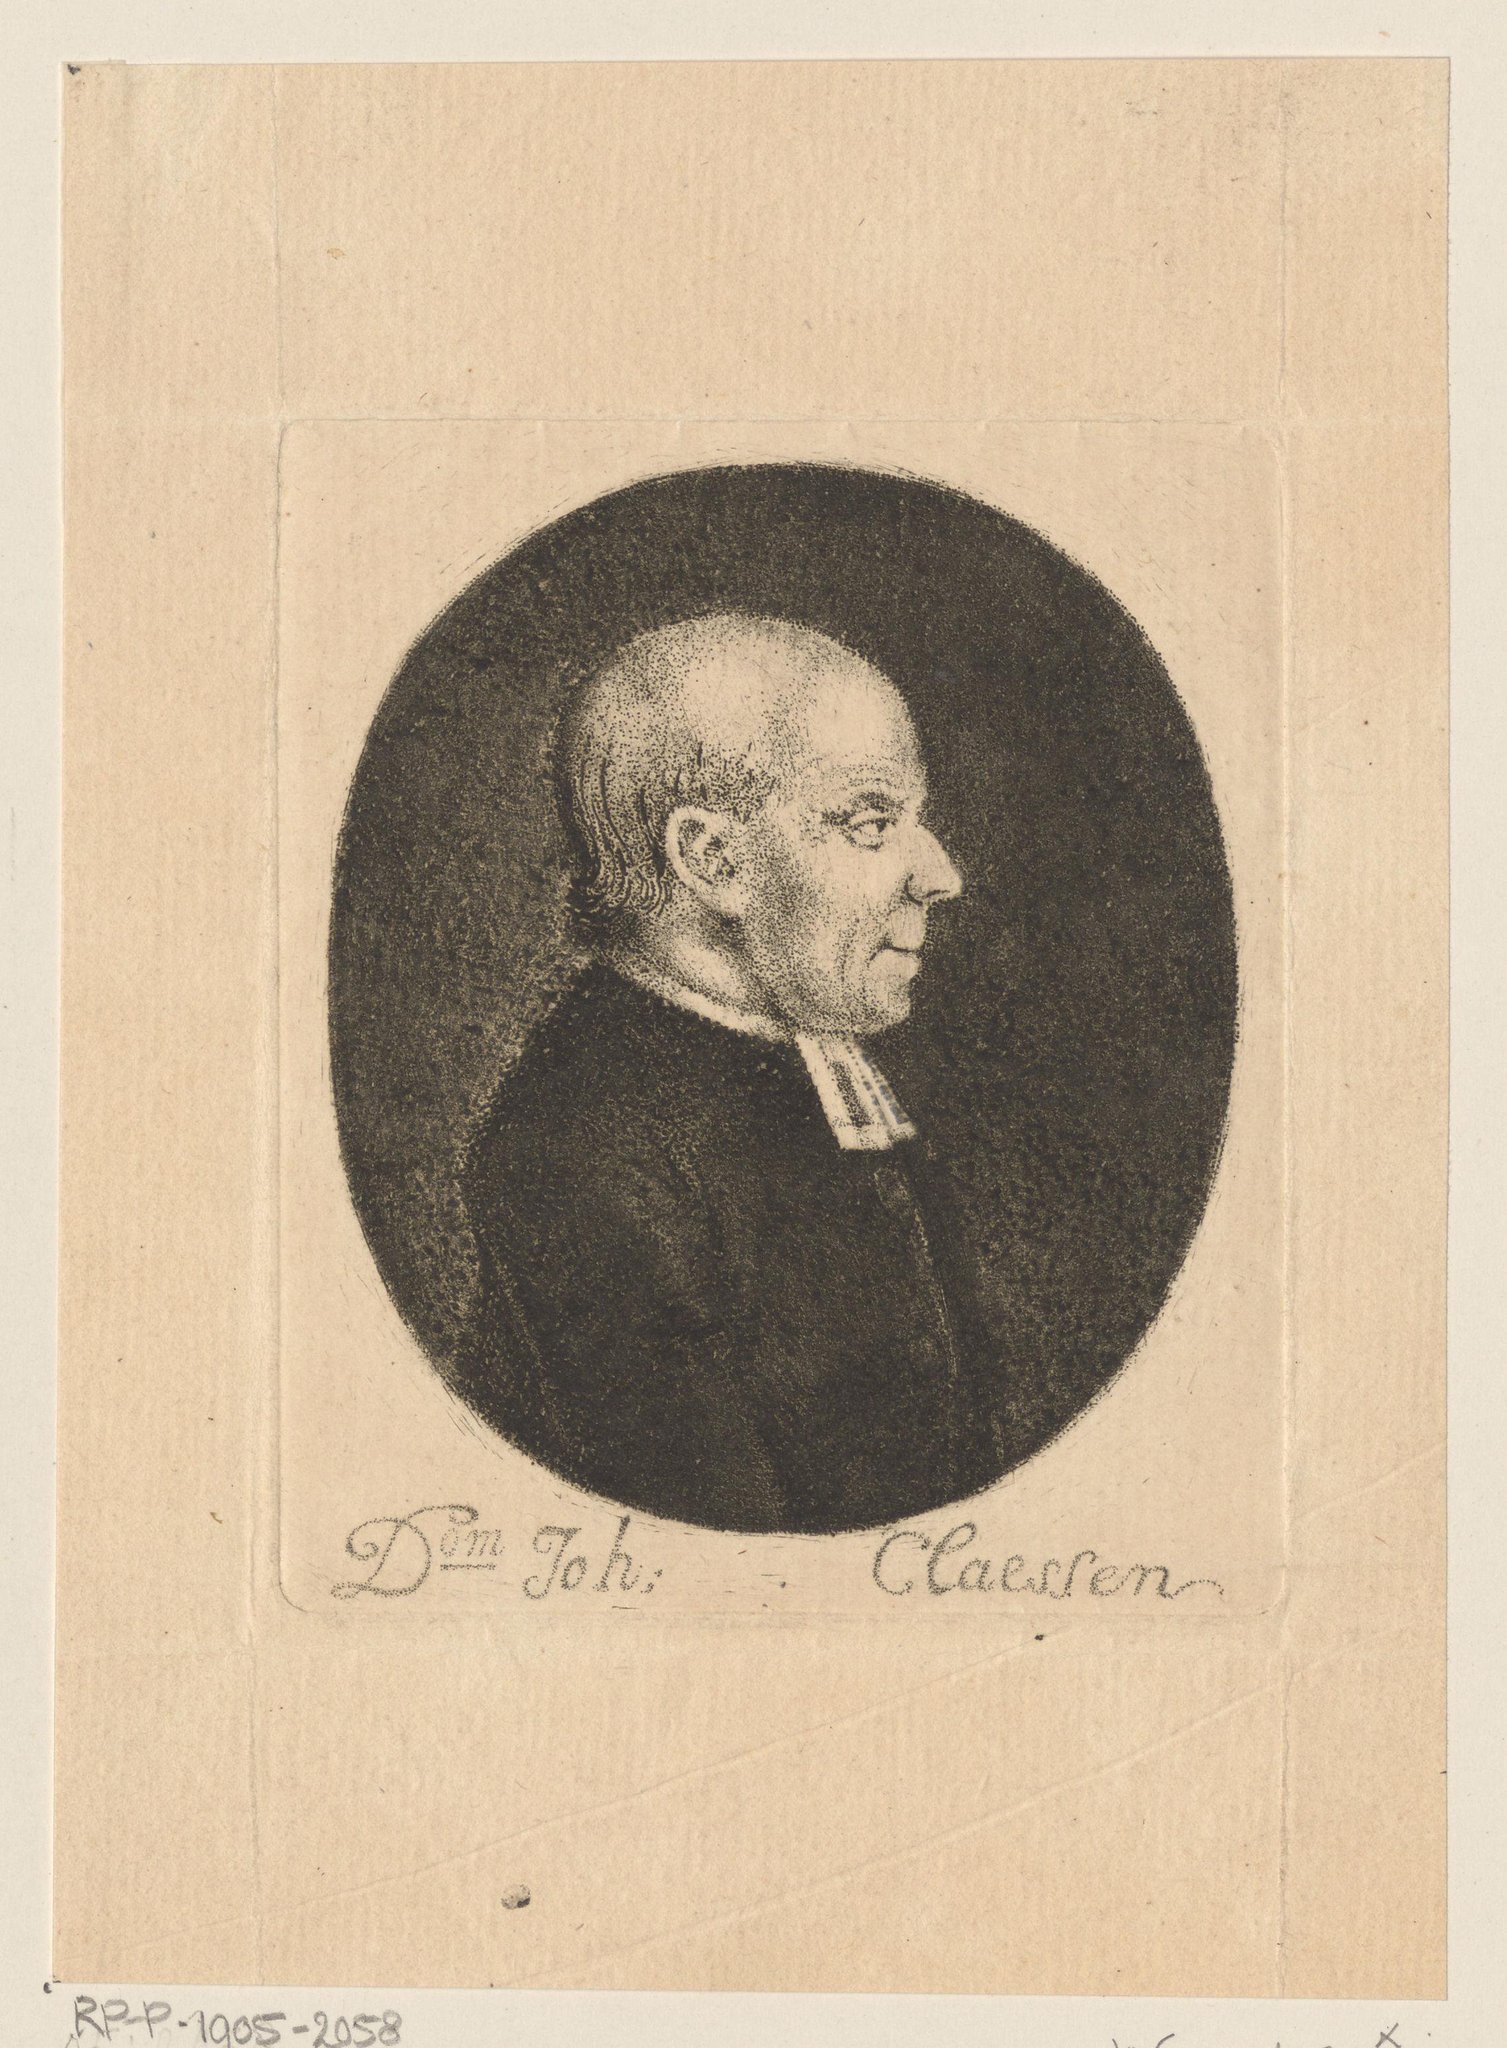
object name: print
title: Portret van Joannes Claessen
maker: Anonymous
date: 1770-1849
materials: paper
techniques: aquatint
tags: maastricht, historical persons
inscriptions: collector's mark: Lugt 2228